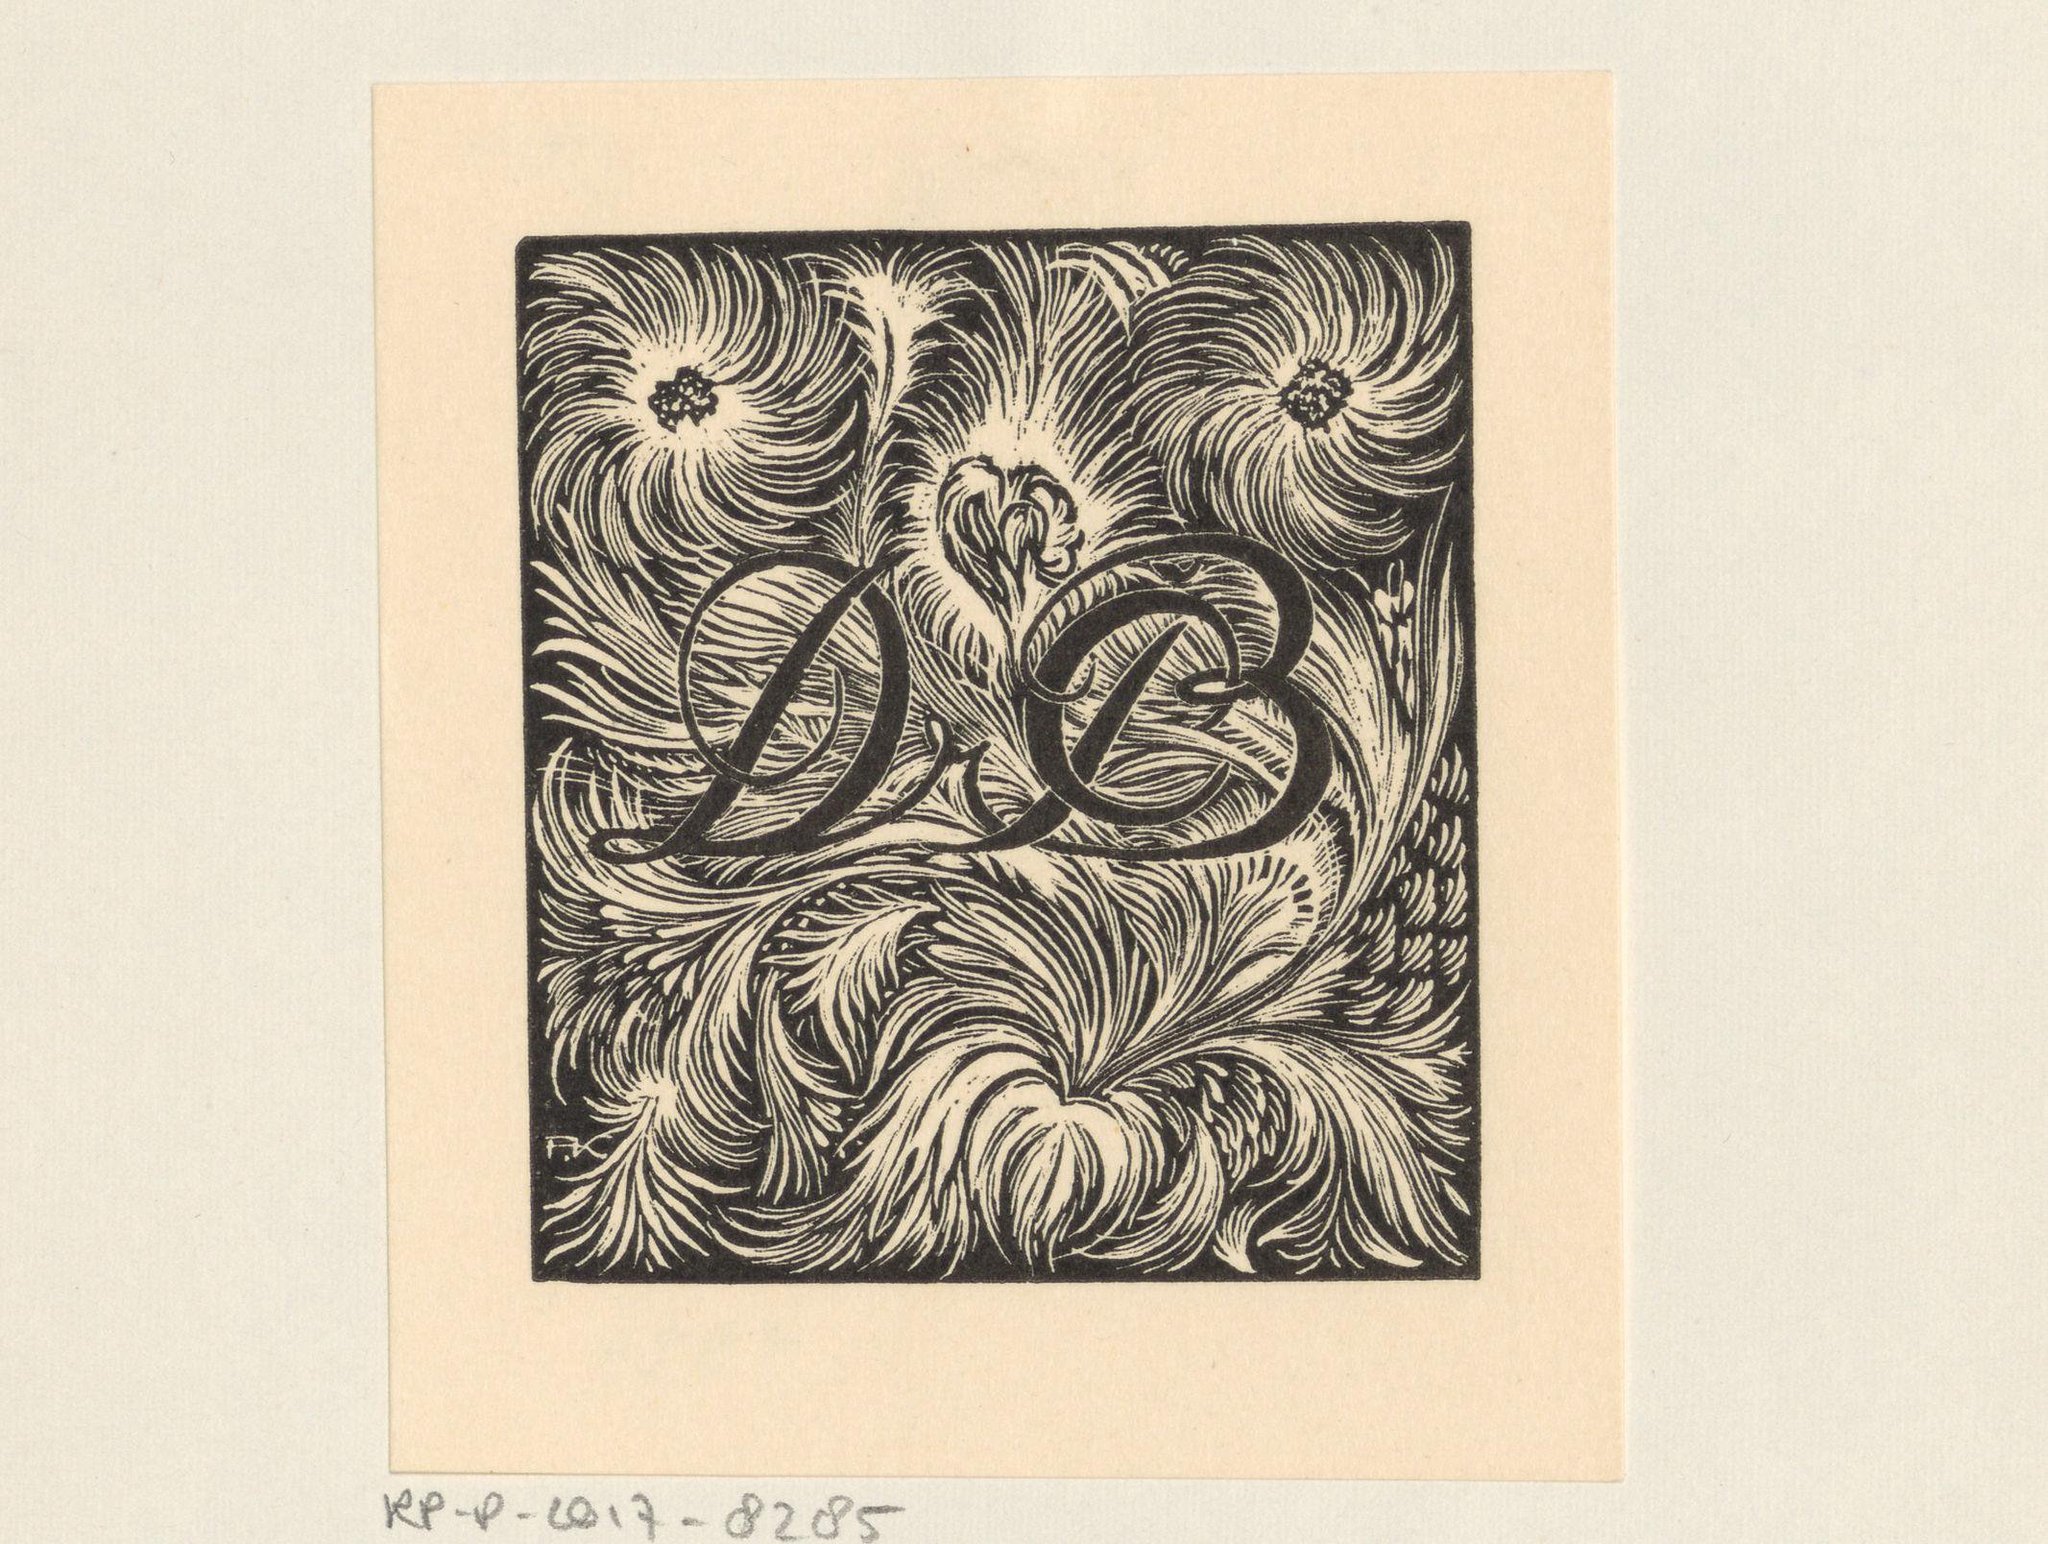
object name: bookplate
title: Ex libris van D.B.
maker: Anonymous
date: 1939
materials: paper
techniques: engraving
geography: czech republic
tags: plants and herbs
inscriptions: inscription: ‘Fr. Koblika [?] Holz/ 1939’